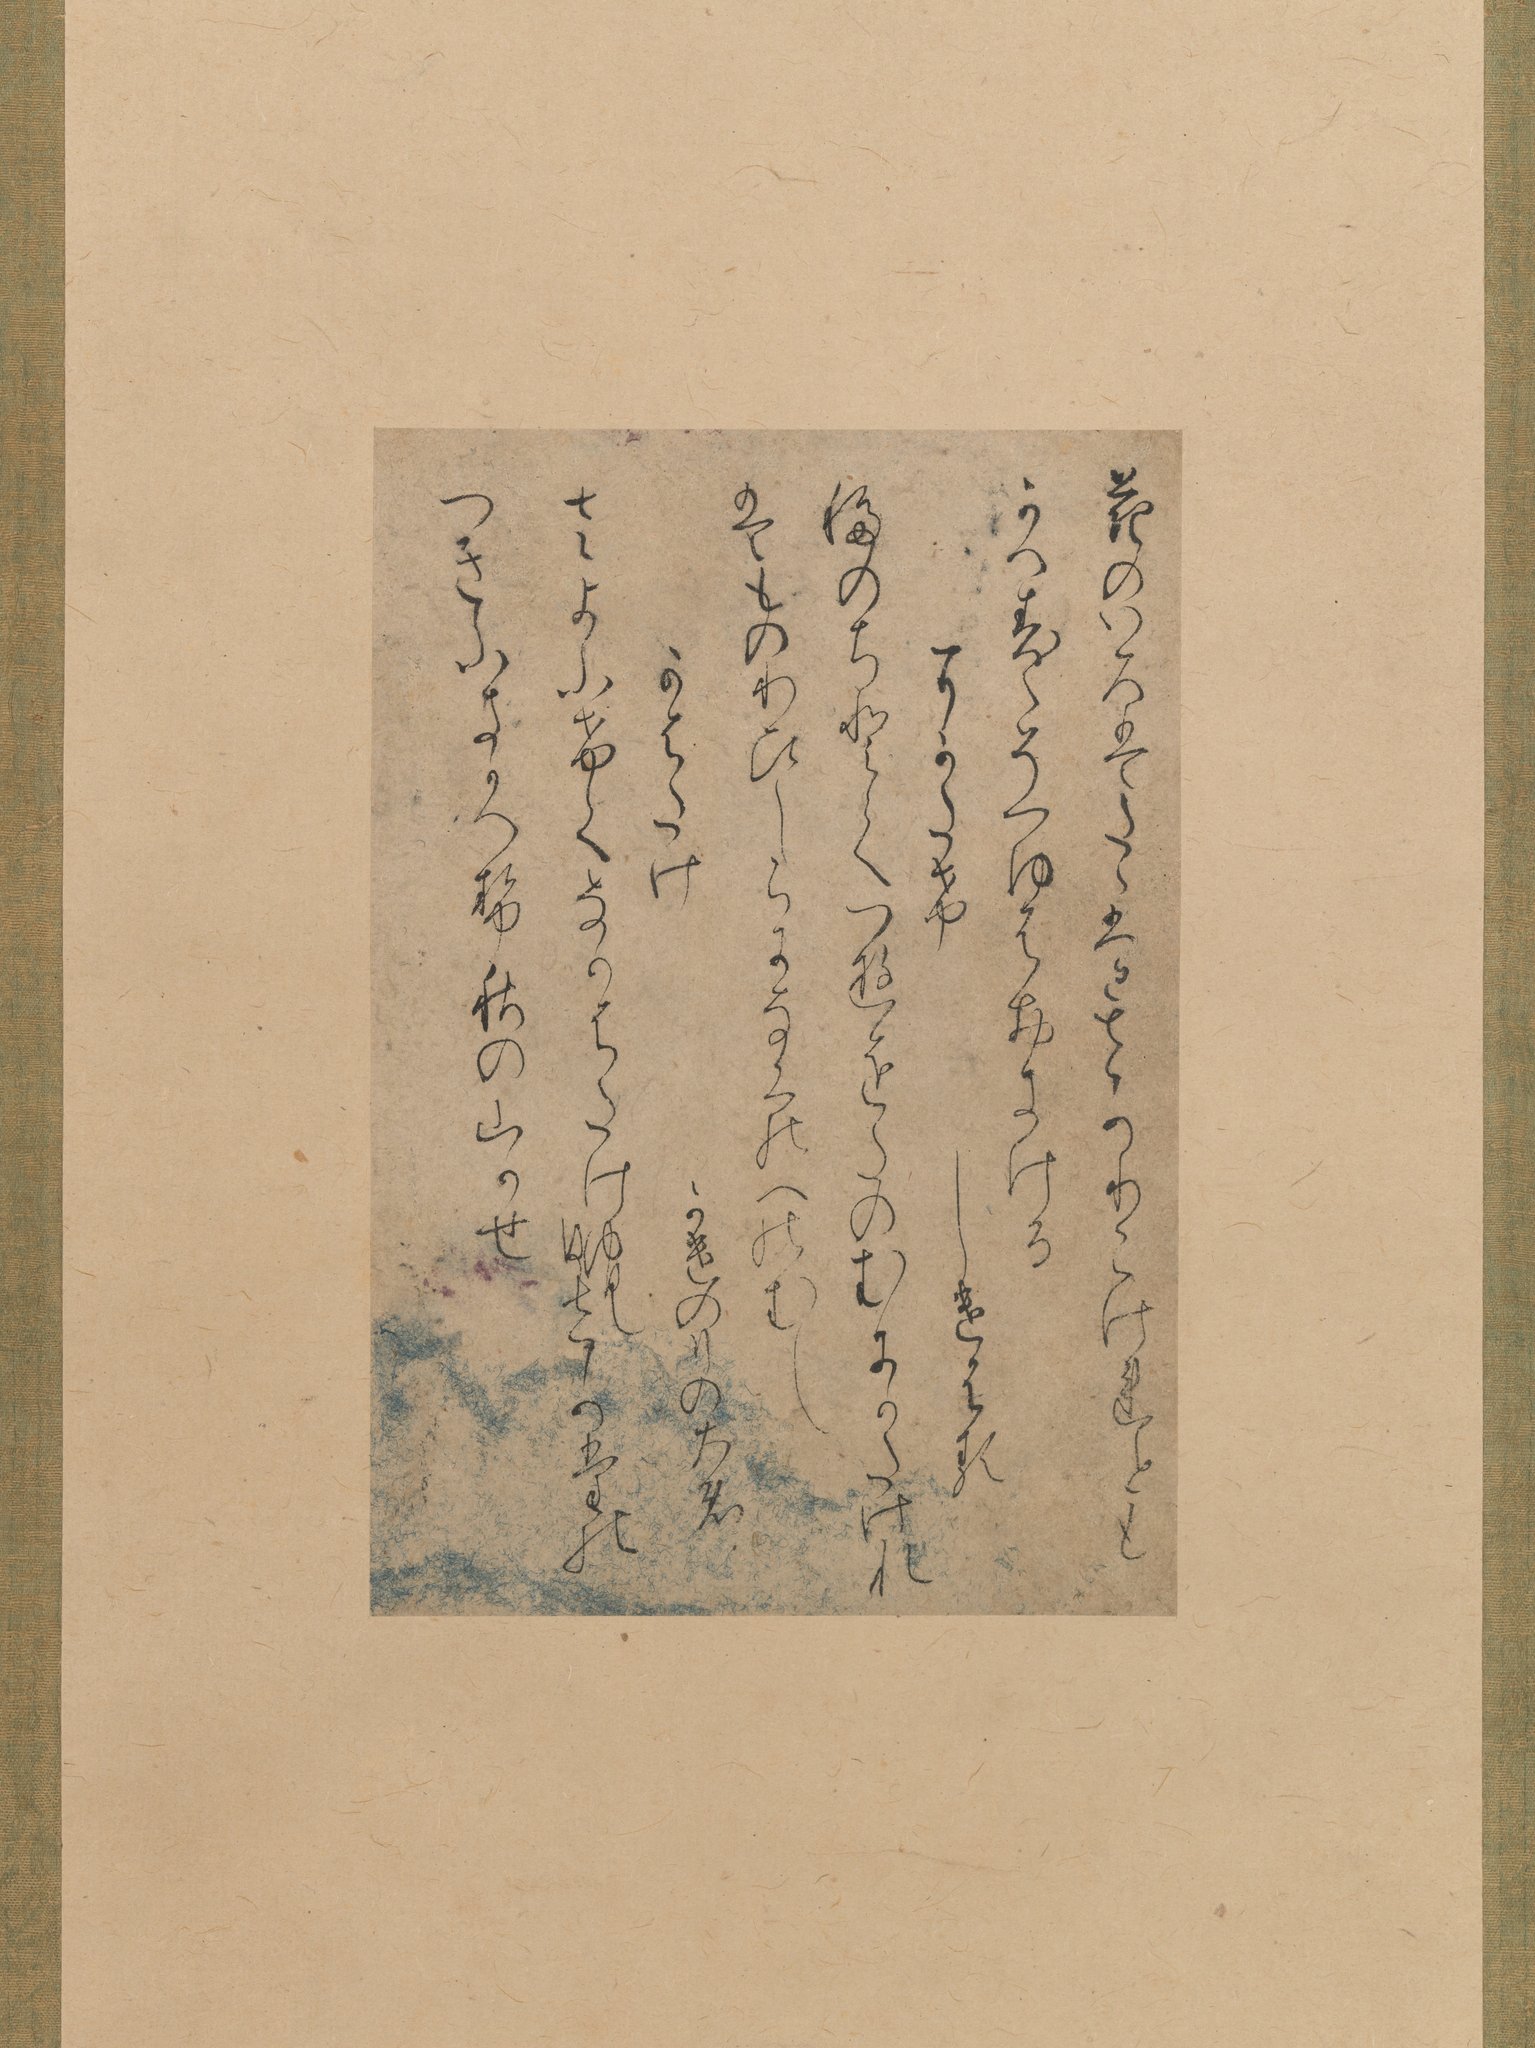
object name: hanging scroll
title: Three Poems from the Collection of Poems Ancient and Modern (Kokin wakashū), one of the Araki Fragments (Araki-gire)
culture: japanese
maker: fujiwara no yukinari (kōzei)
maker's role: artist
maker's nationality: japanese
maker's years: 972-1027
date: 1001-1100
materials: ink, paper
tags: poetry